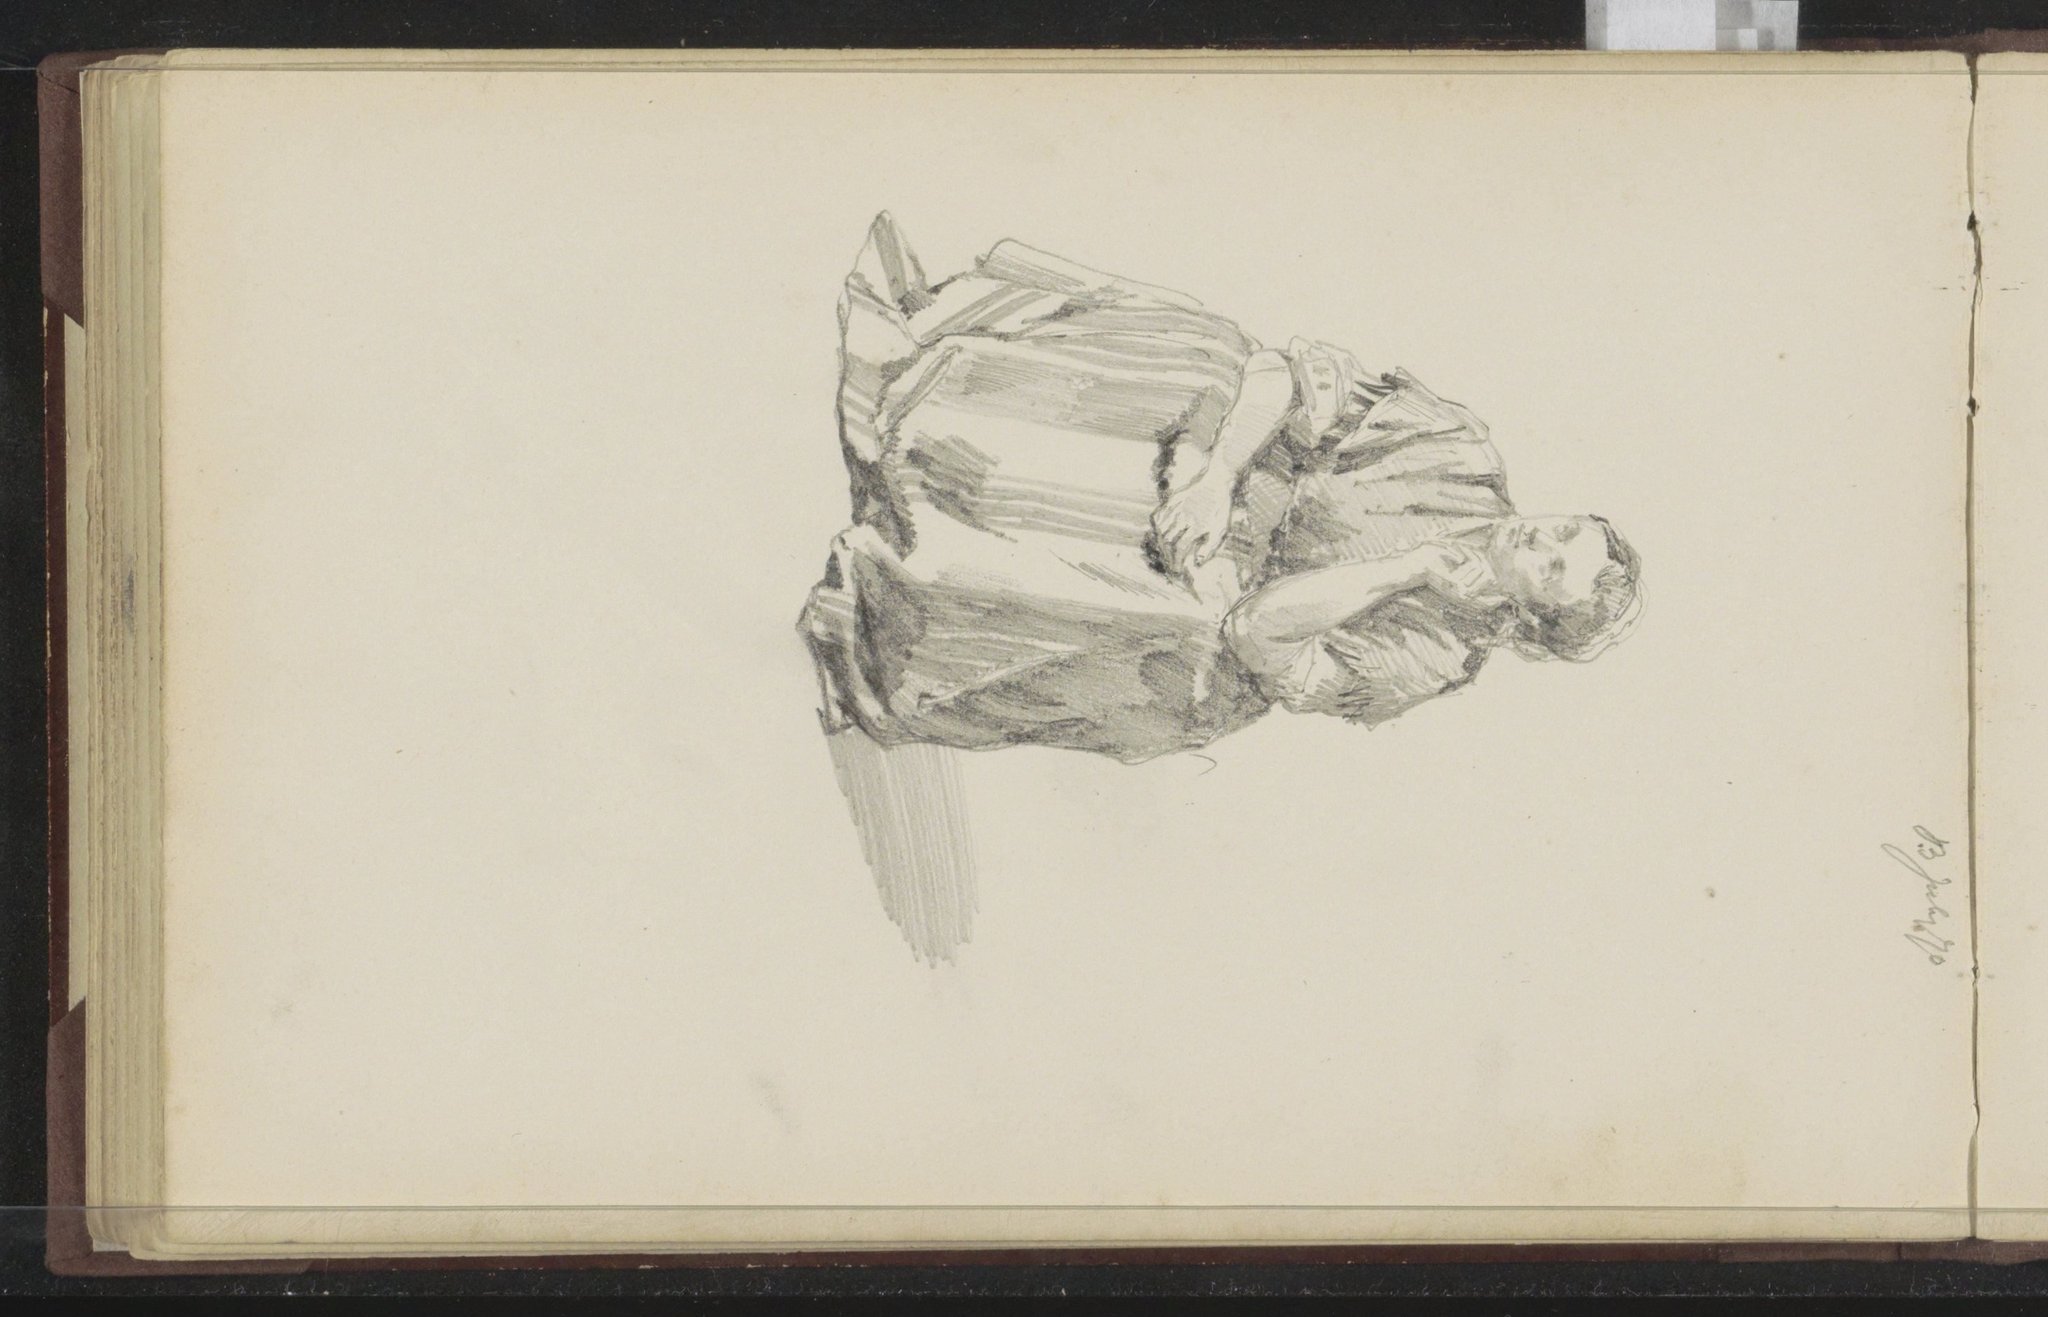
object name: sketchbook leaf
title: Zittende vrouw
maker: cornelis springer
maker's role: draughtsman, painter, print maker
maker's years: 1817-1891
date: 1870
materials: paper, pencil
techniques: stumping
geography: netherlands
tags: adult woman, sitting on an elevation - aa - female human figure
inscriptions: date: ‘13 July 70’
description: Zittende vrouw. Ze ondersteunt haar hoofd met haar hand. Blad 36 verso uit een schetsboek met 39 bladen, deels vervaardigd te Ulm en Leiden.